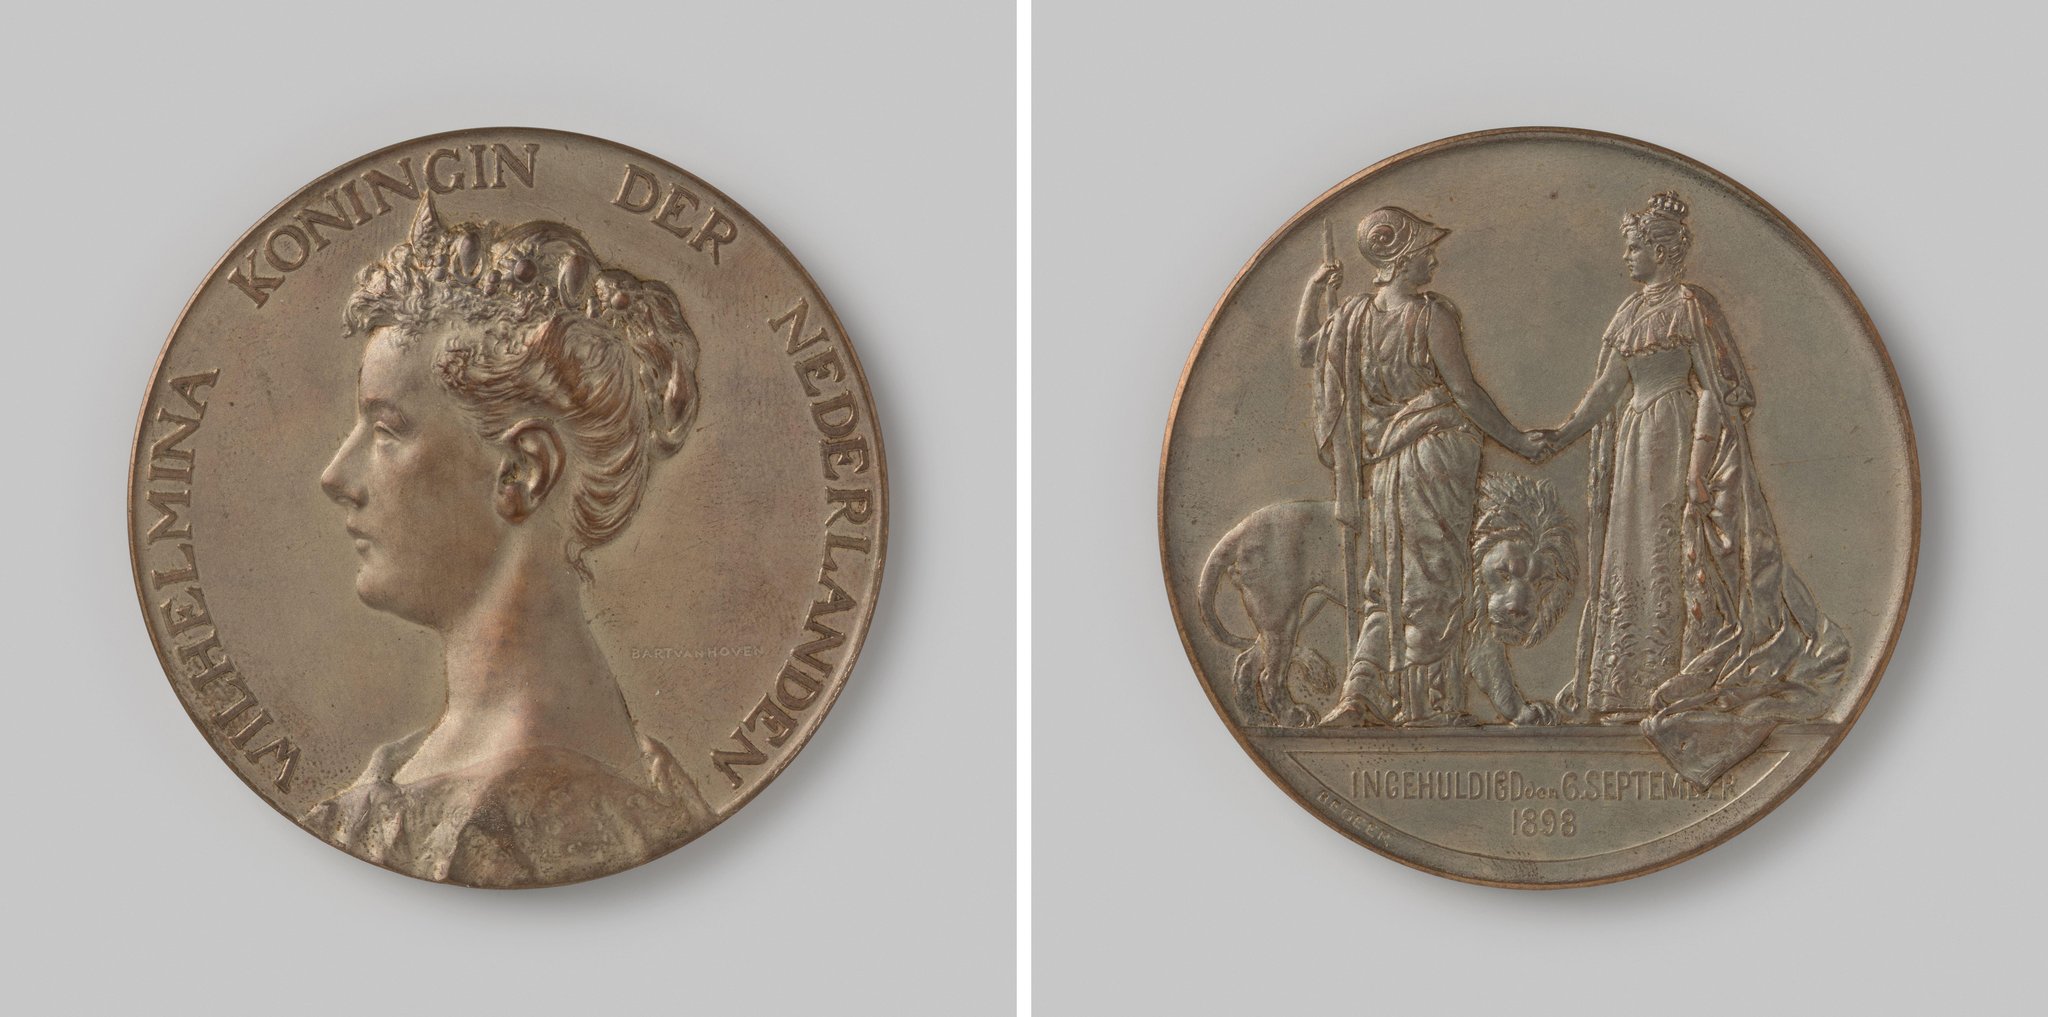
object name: history medal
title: Inhuldiging van Koningin Wilhelmina 1898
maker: bart van hove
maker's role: sculptor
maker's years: 1850-1914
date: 1898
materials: copper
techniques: striking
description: Verzilverde penning, op de voorzijde het borstbeeld van Wilhelmina naar links met omschrift, op de keerzijde de Nederlandse Maagd met speer, een leeuw aan haar voeten, drukt de hand van de nieuwe koningin, met afsnedetekst.